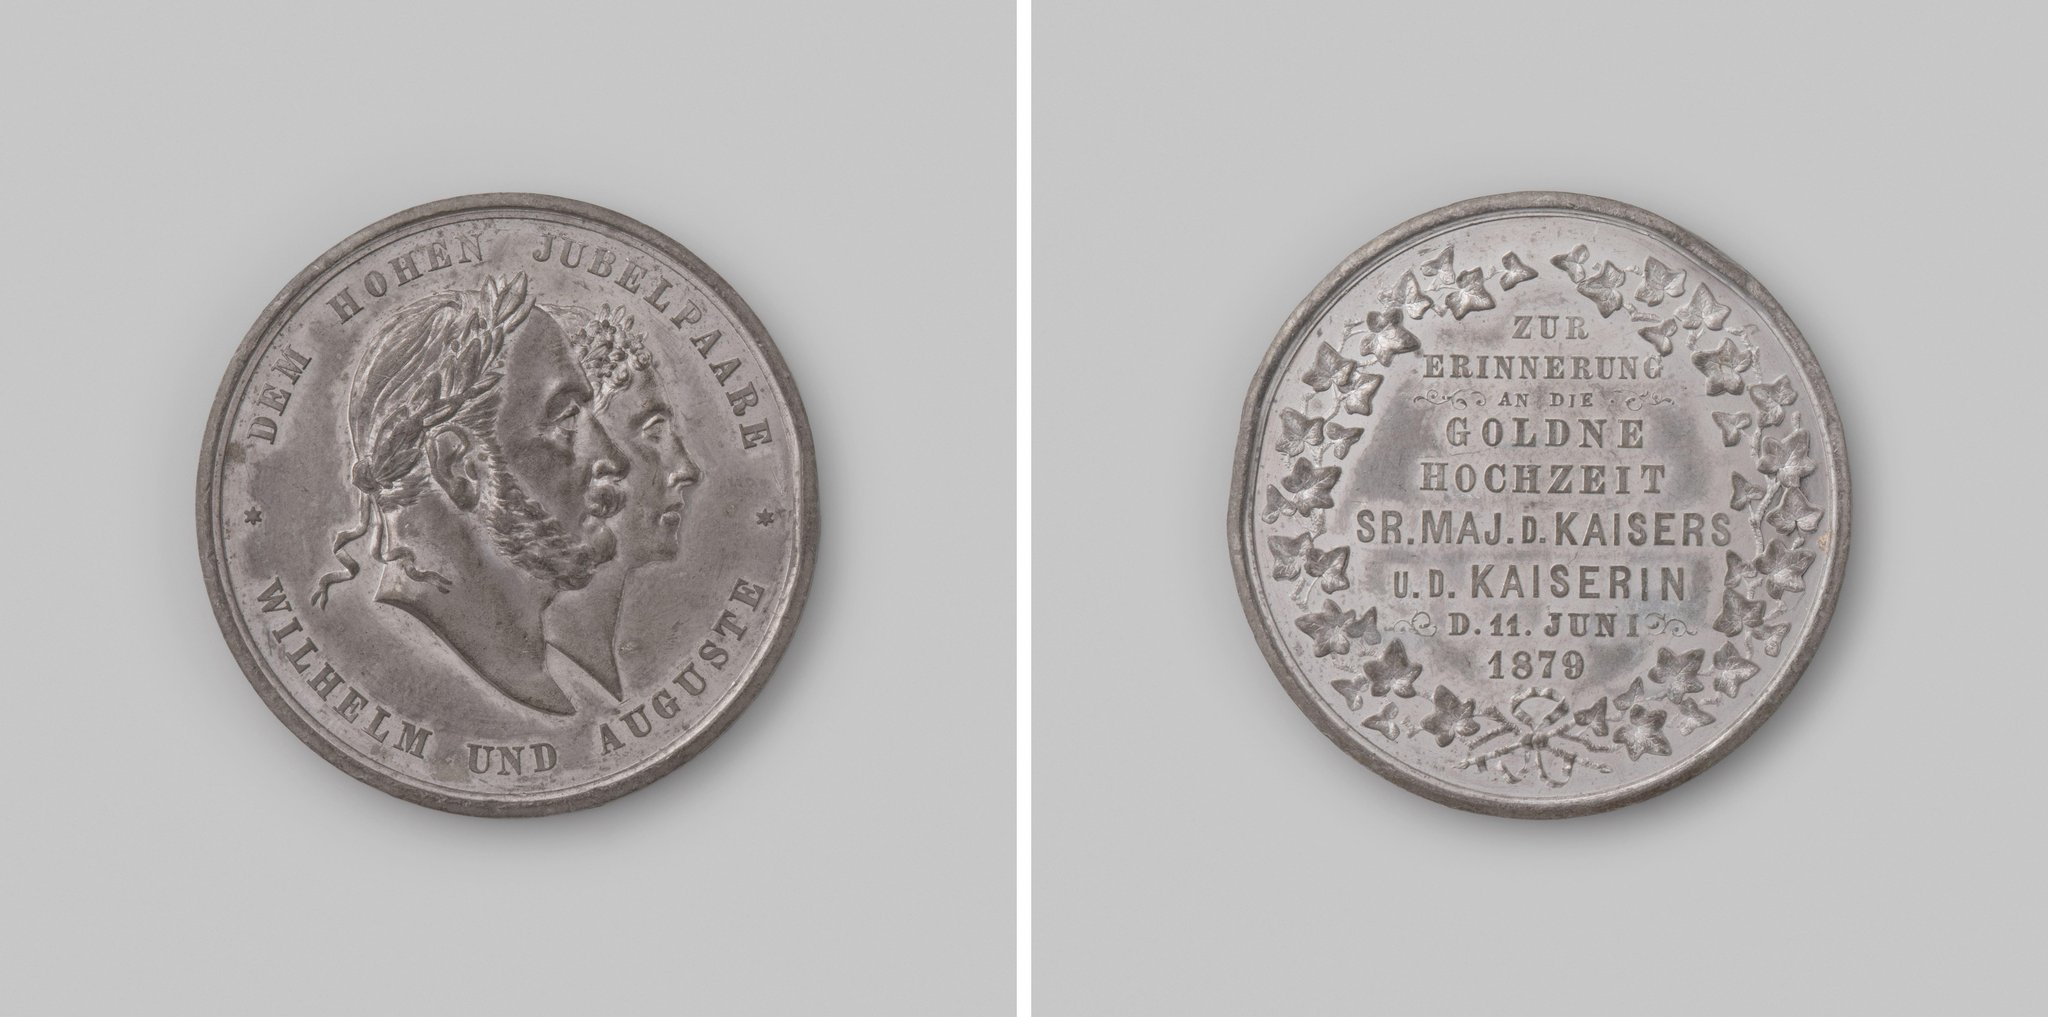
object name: history medal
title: Vijftigjarig huwelijk van Keizer Wilhelm I en Keizerin Augusta van Duitsland 1879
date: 1879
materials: tin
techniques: striking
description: Tinnen penning, op de voorzijde de geconjugeerde portretten van Wilhelm en Augusta naar rechts met omschrift, op de keerzijde negen regels tekst tussen samengestrikte druivenranken.